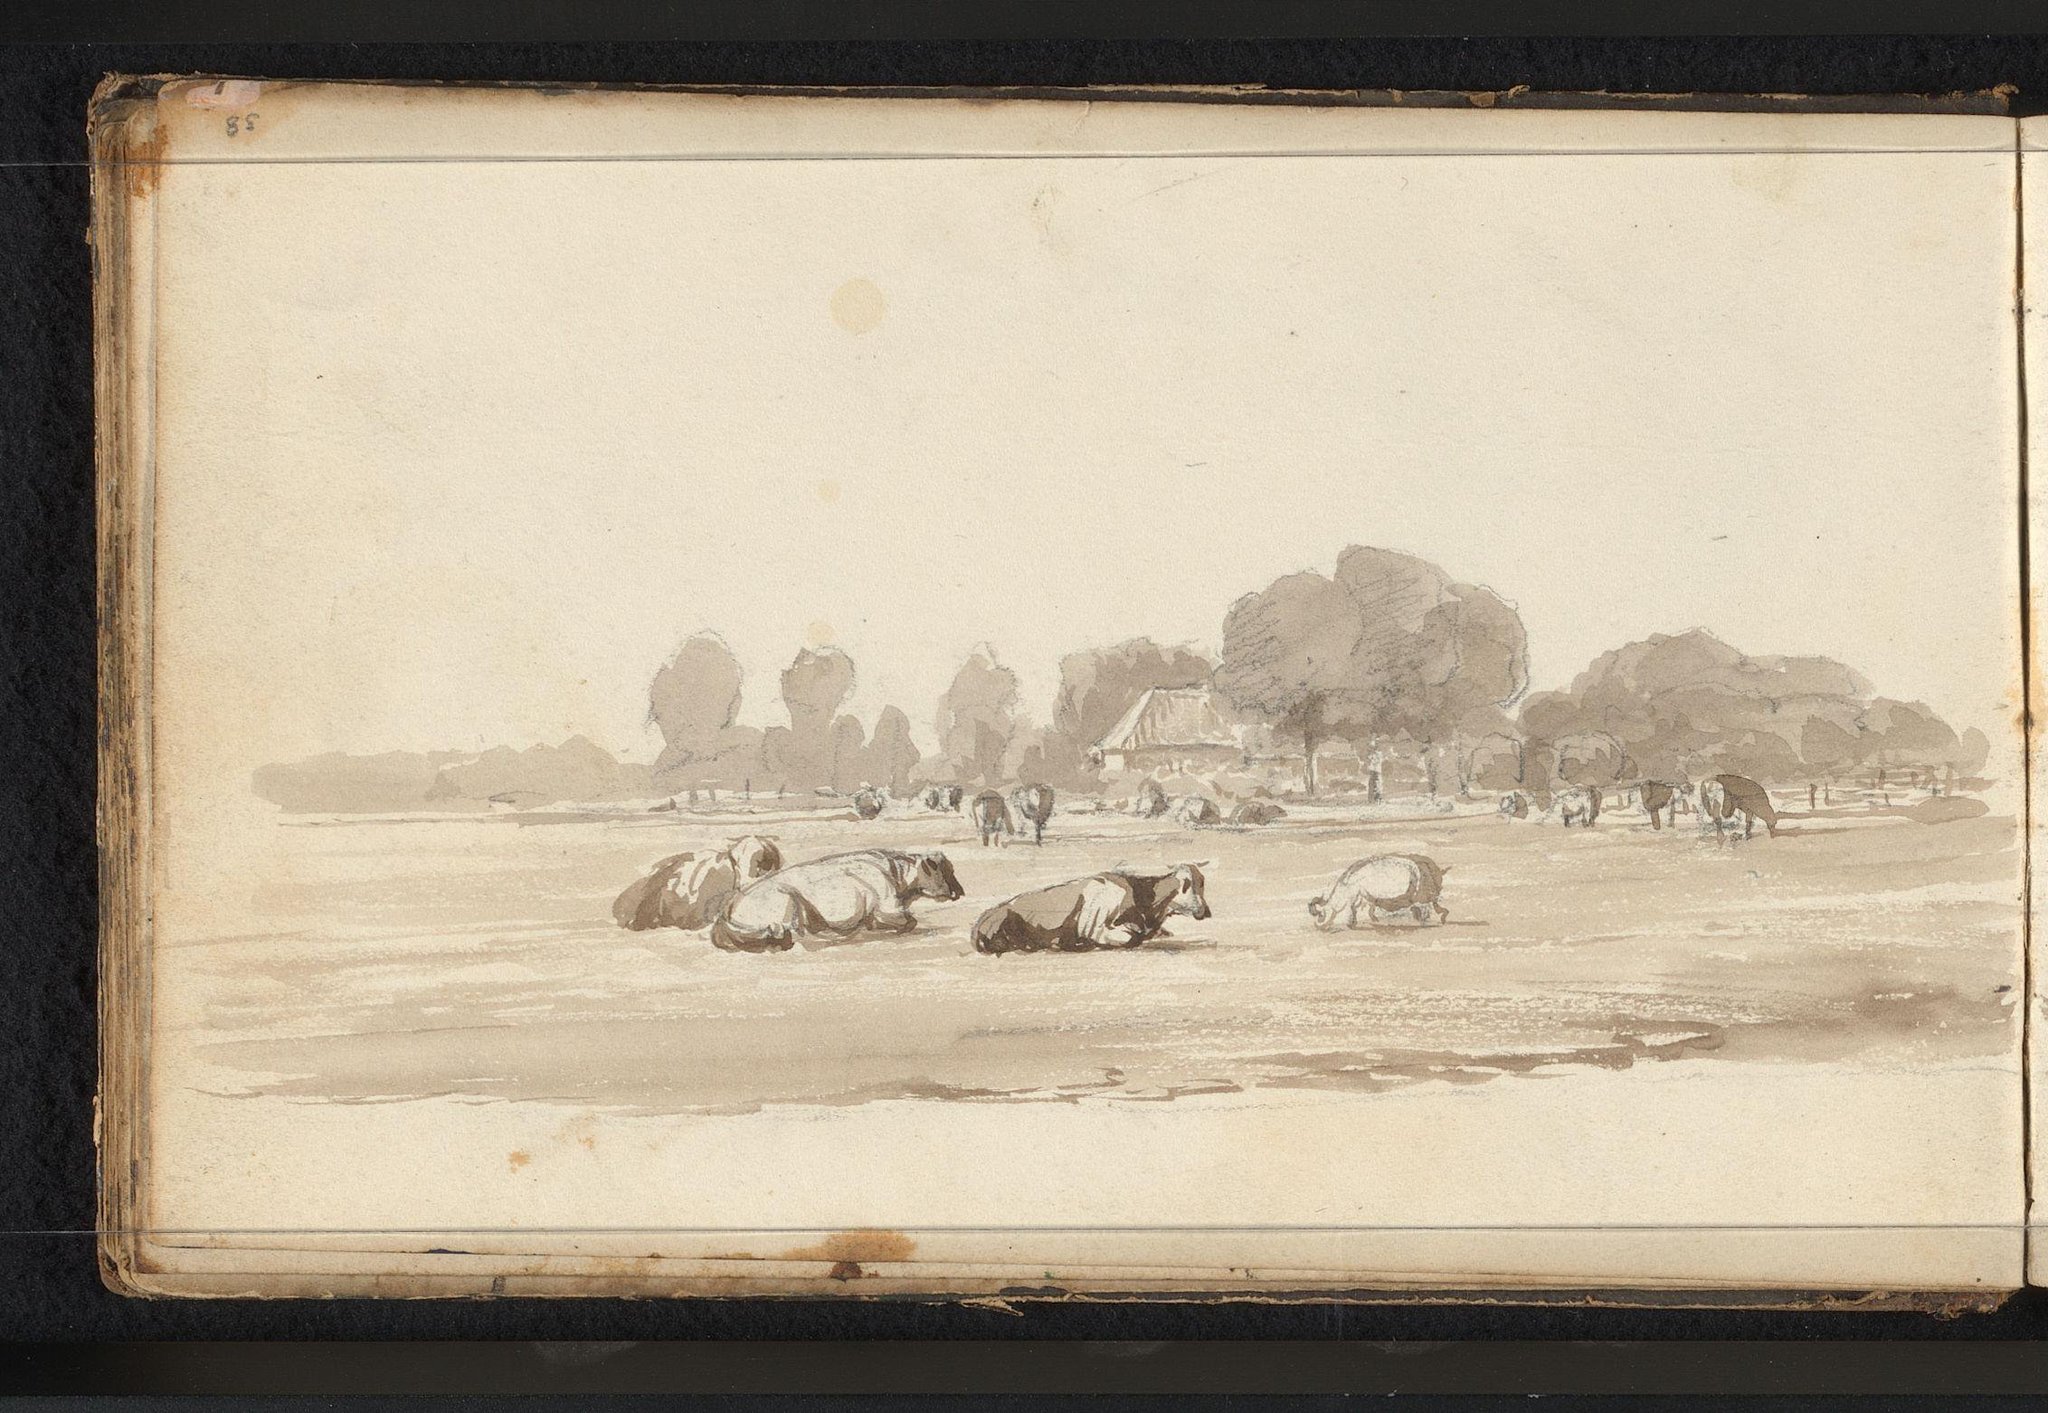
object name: sketchbook leaf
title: Runderen in een weiland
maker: jan bedijs tom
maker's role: draughtsman, painter, print maker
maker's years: 1813-1894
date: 1828-1894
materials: paper, pencil, watercolor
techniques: brush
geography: the hague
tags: landscapes, meadow, pasture, artist (in general) making preliminary designs, sketching, bovine cattle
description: Pagina 38 recto uit een schetsboek met 54 bladen.